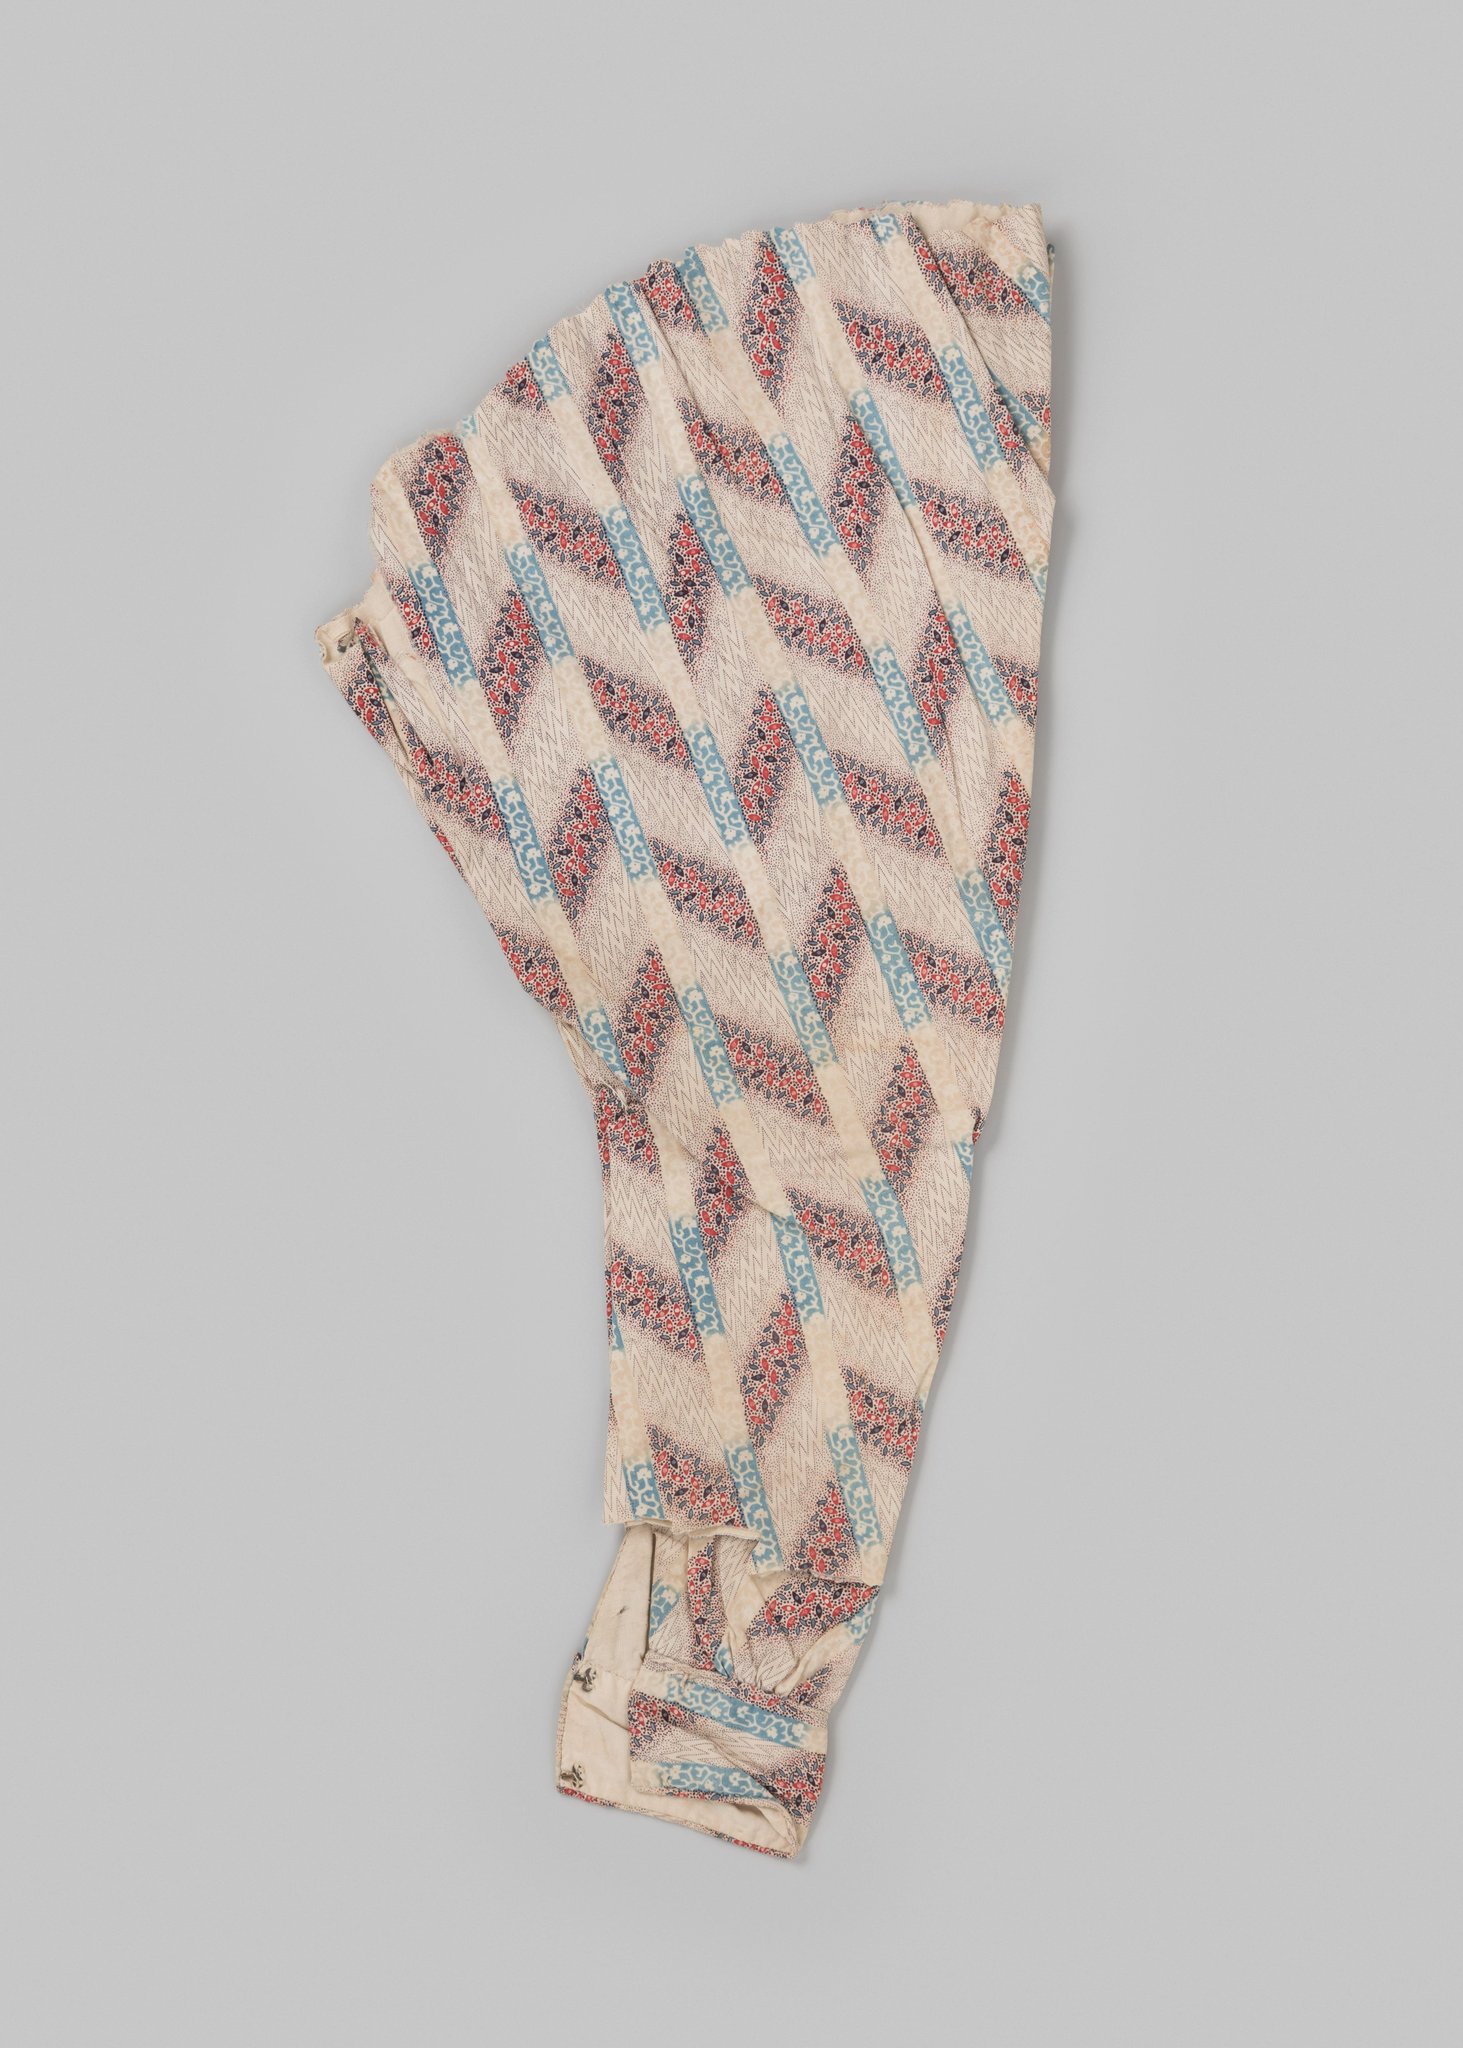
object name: sleeve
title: Mouw van wit katoen bedrukt in de kleuren roze, rood, paars en blauw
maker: Anonymous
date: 1825-1850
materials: cotton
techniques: printing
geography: netherlands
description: Mouw, gevoerd, van een vrouwenjak van bedrukte katoen. Het patroon bestaat uit een smalle streep met een doorlopend bloemmotief naast een bredere streep met daarin een motief van twee verschillende elkaar afwisselende ruiten. De ruiten zijn gedecoreerd met donkere stippels. De ene ruit kent een zigzagmotief en de andere is versierd met stippen en ovalen. Het patroon is gedrukt met de kleuren rood, roze, paars en blauw op een wit fond. De manchet van de mouw is afgeknipt en ontbreekt.